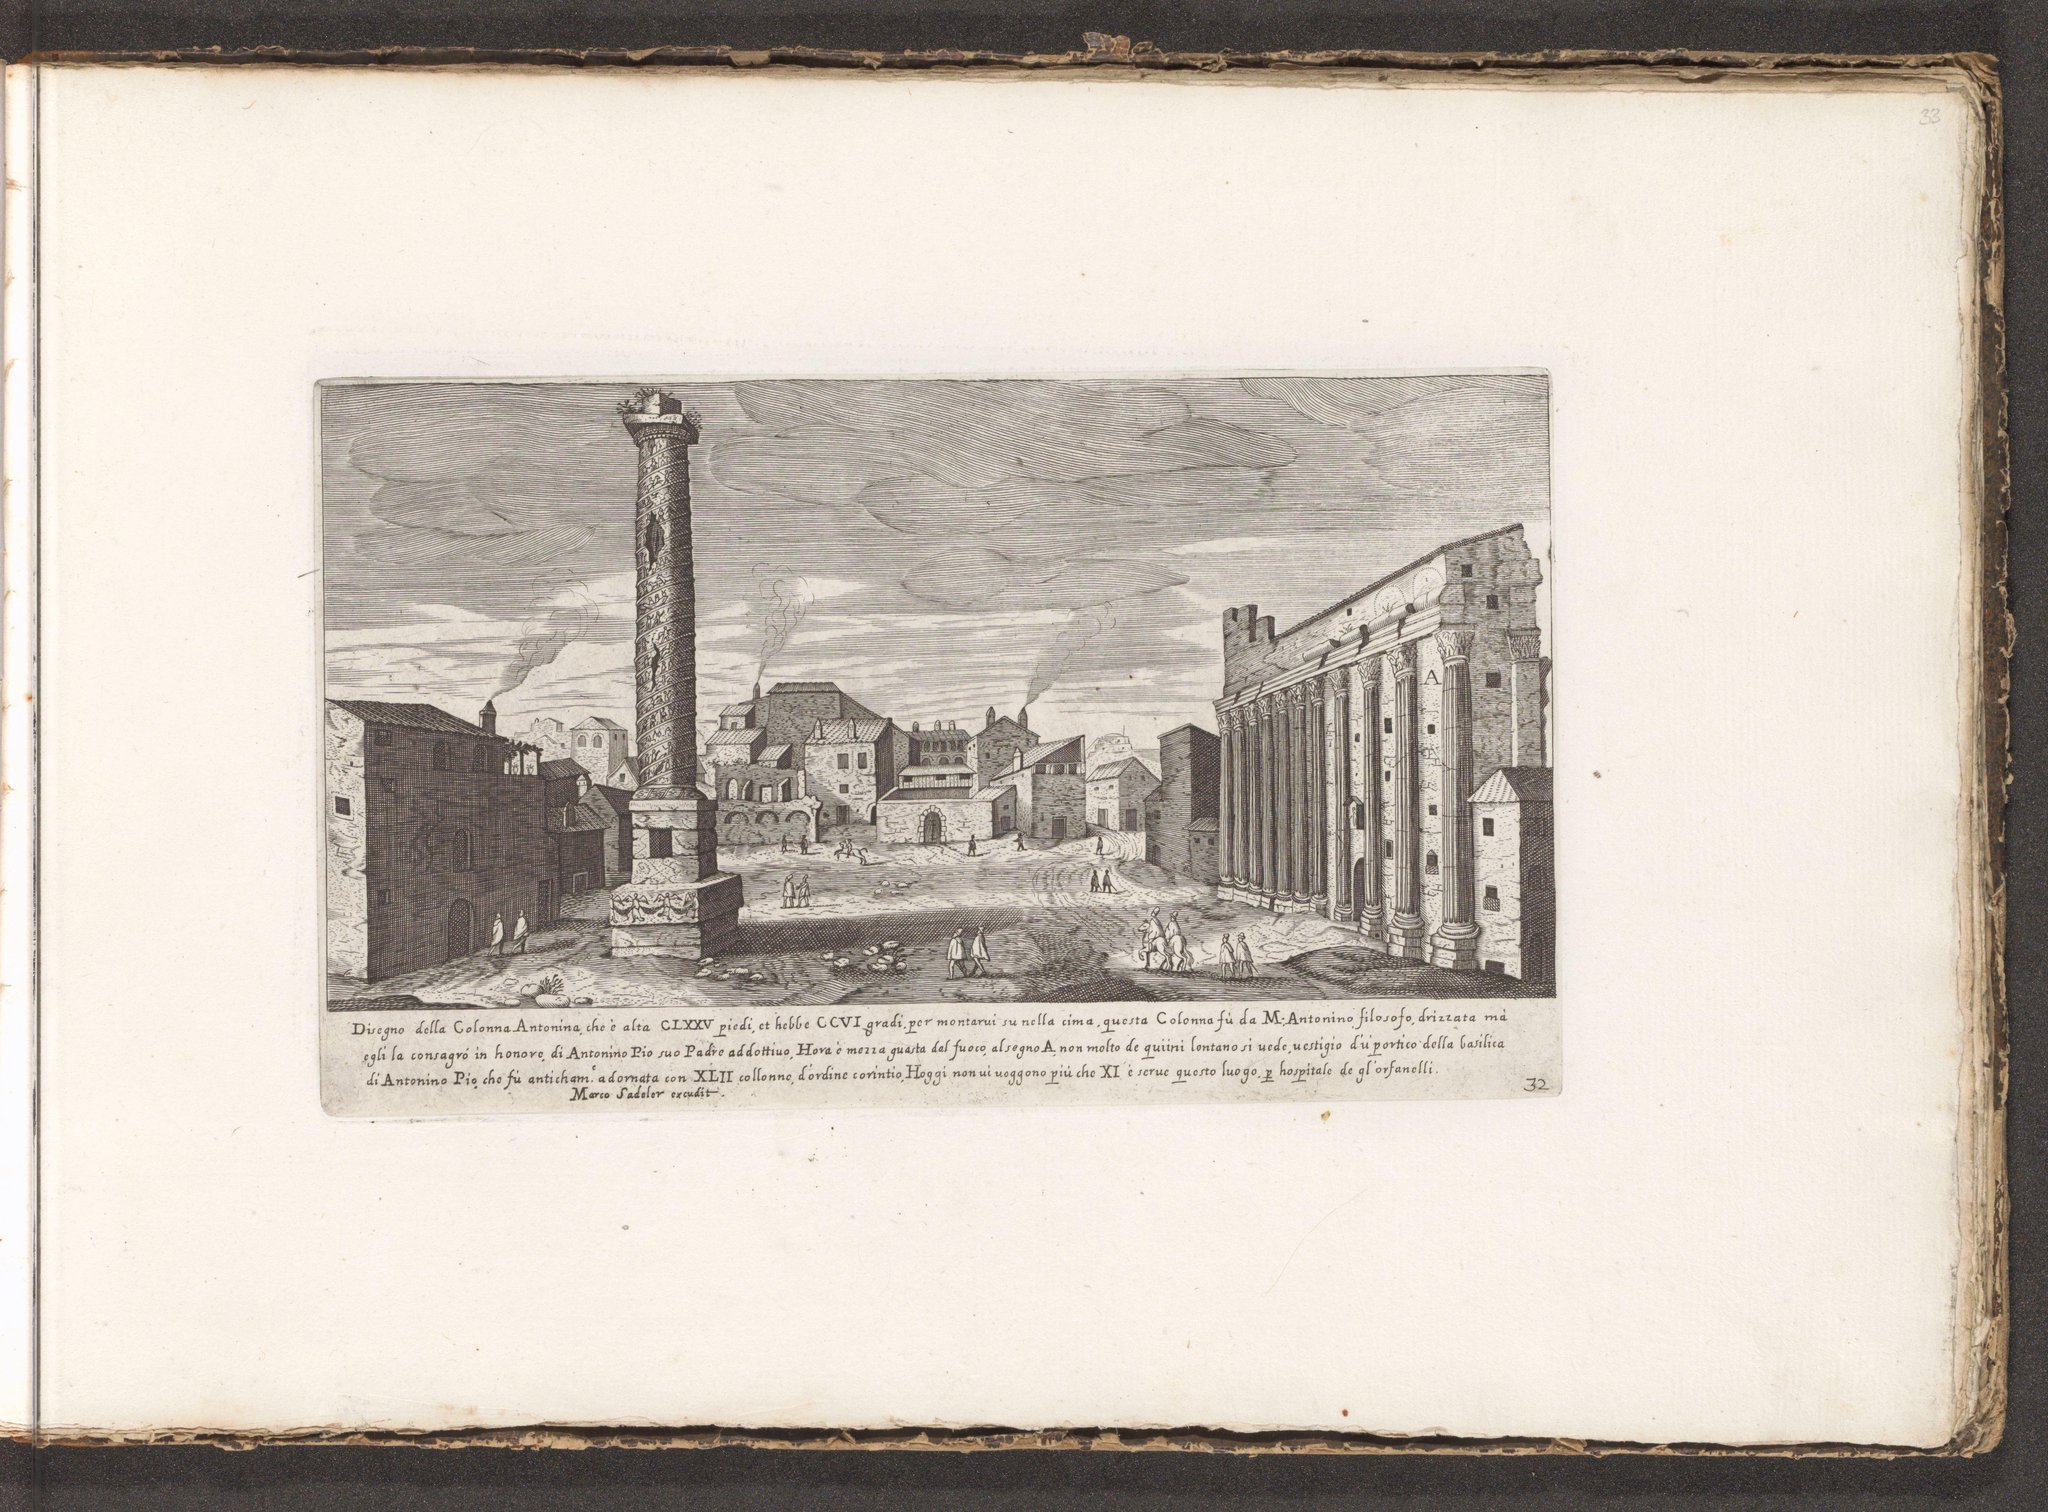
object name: album leaf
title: Vestigi delle antichita di Roma, Tivoli, Pozzuolo et altri luochi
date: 1680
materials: paper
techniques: engraving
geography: rome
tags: rome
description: De Zuil van Marcus Aurelius, hier aangeduid als de Zuil van Antoninus Pius. Rechts de Tempel van Hadrianus. In de ondermarge drie regels tekst in het Italiaans. De prent maakt deel uit van een album.